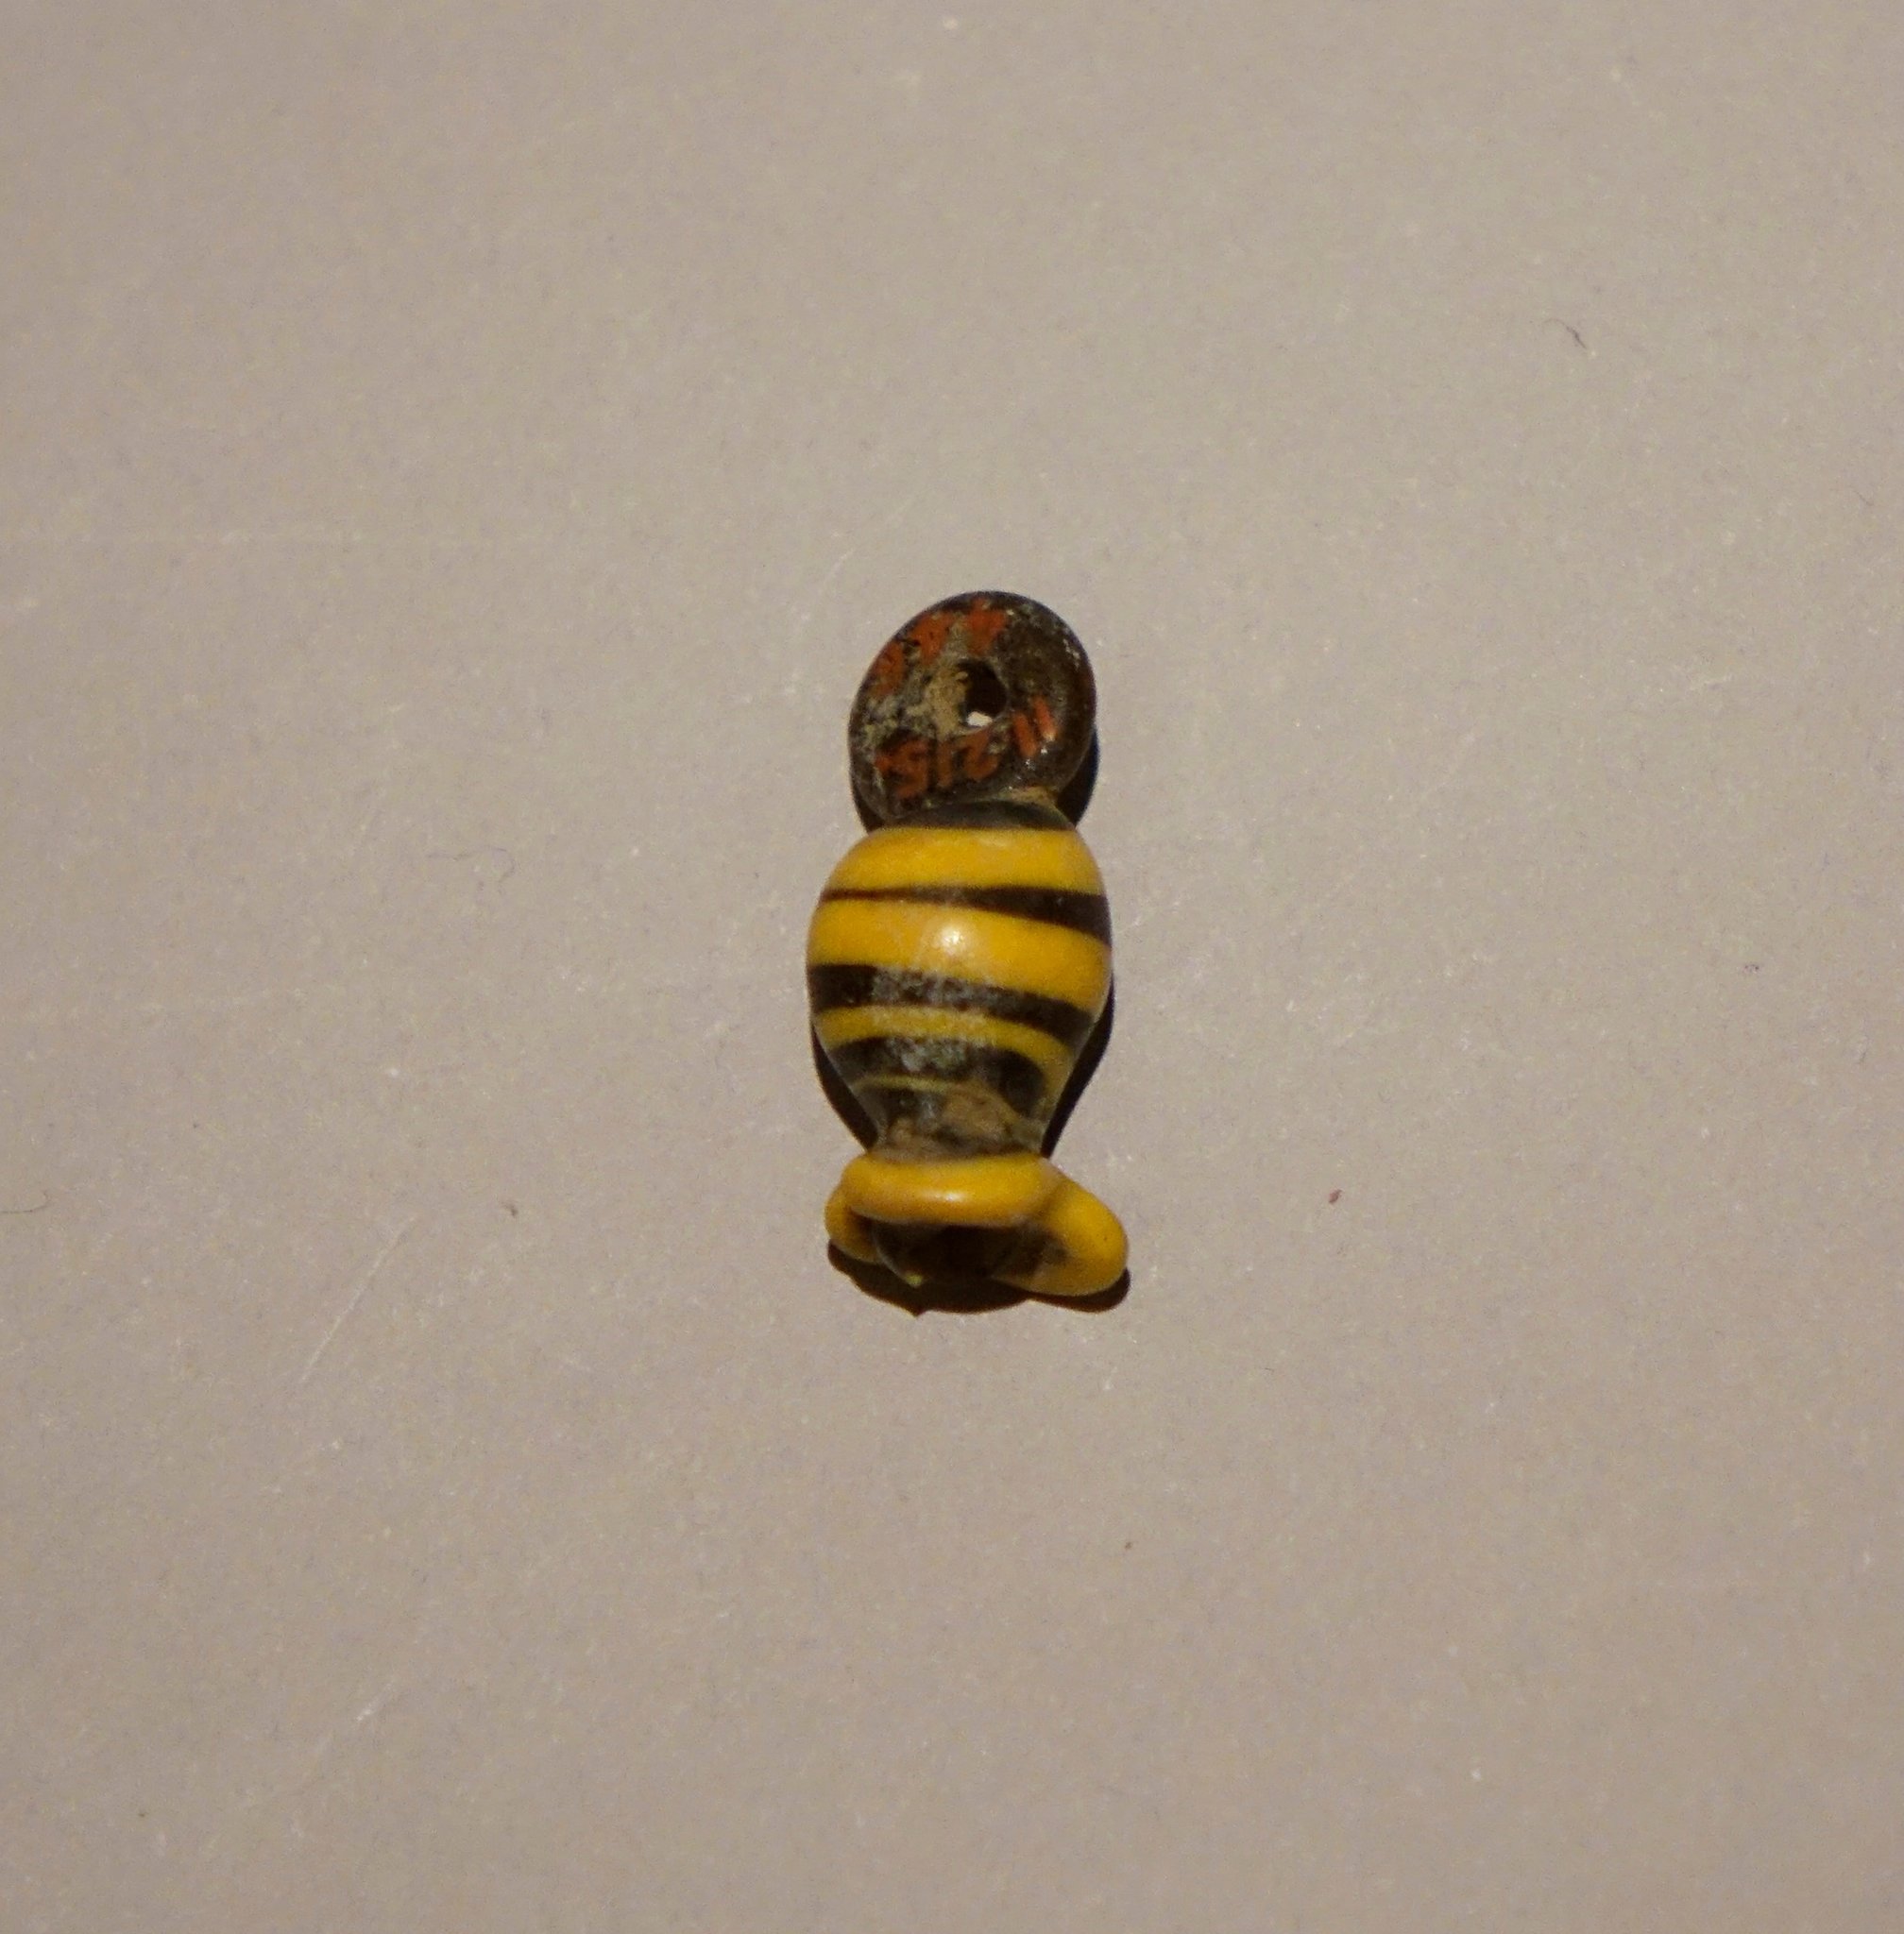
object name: pendant, pomegranate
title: Pomegranate Pendant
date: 1390-1352 BCE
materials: glass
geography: egypt